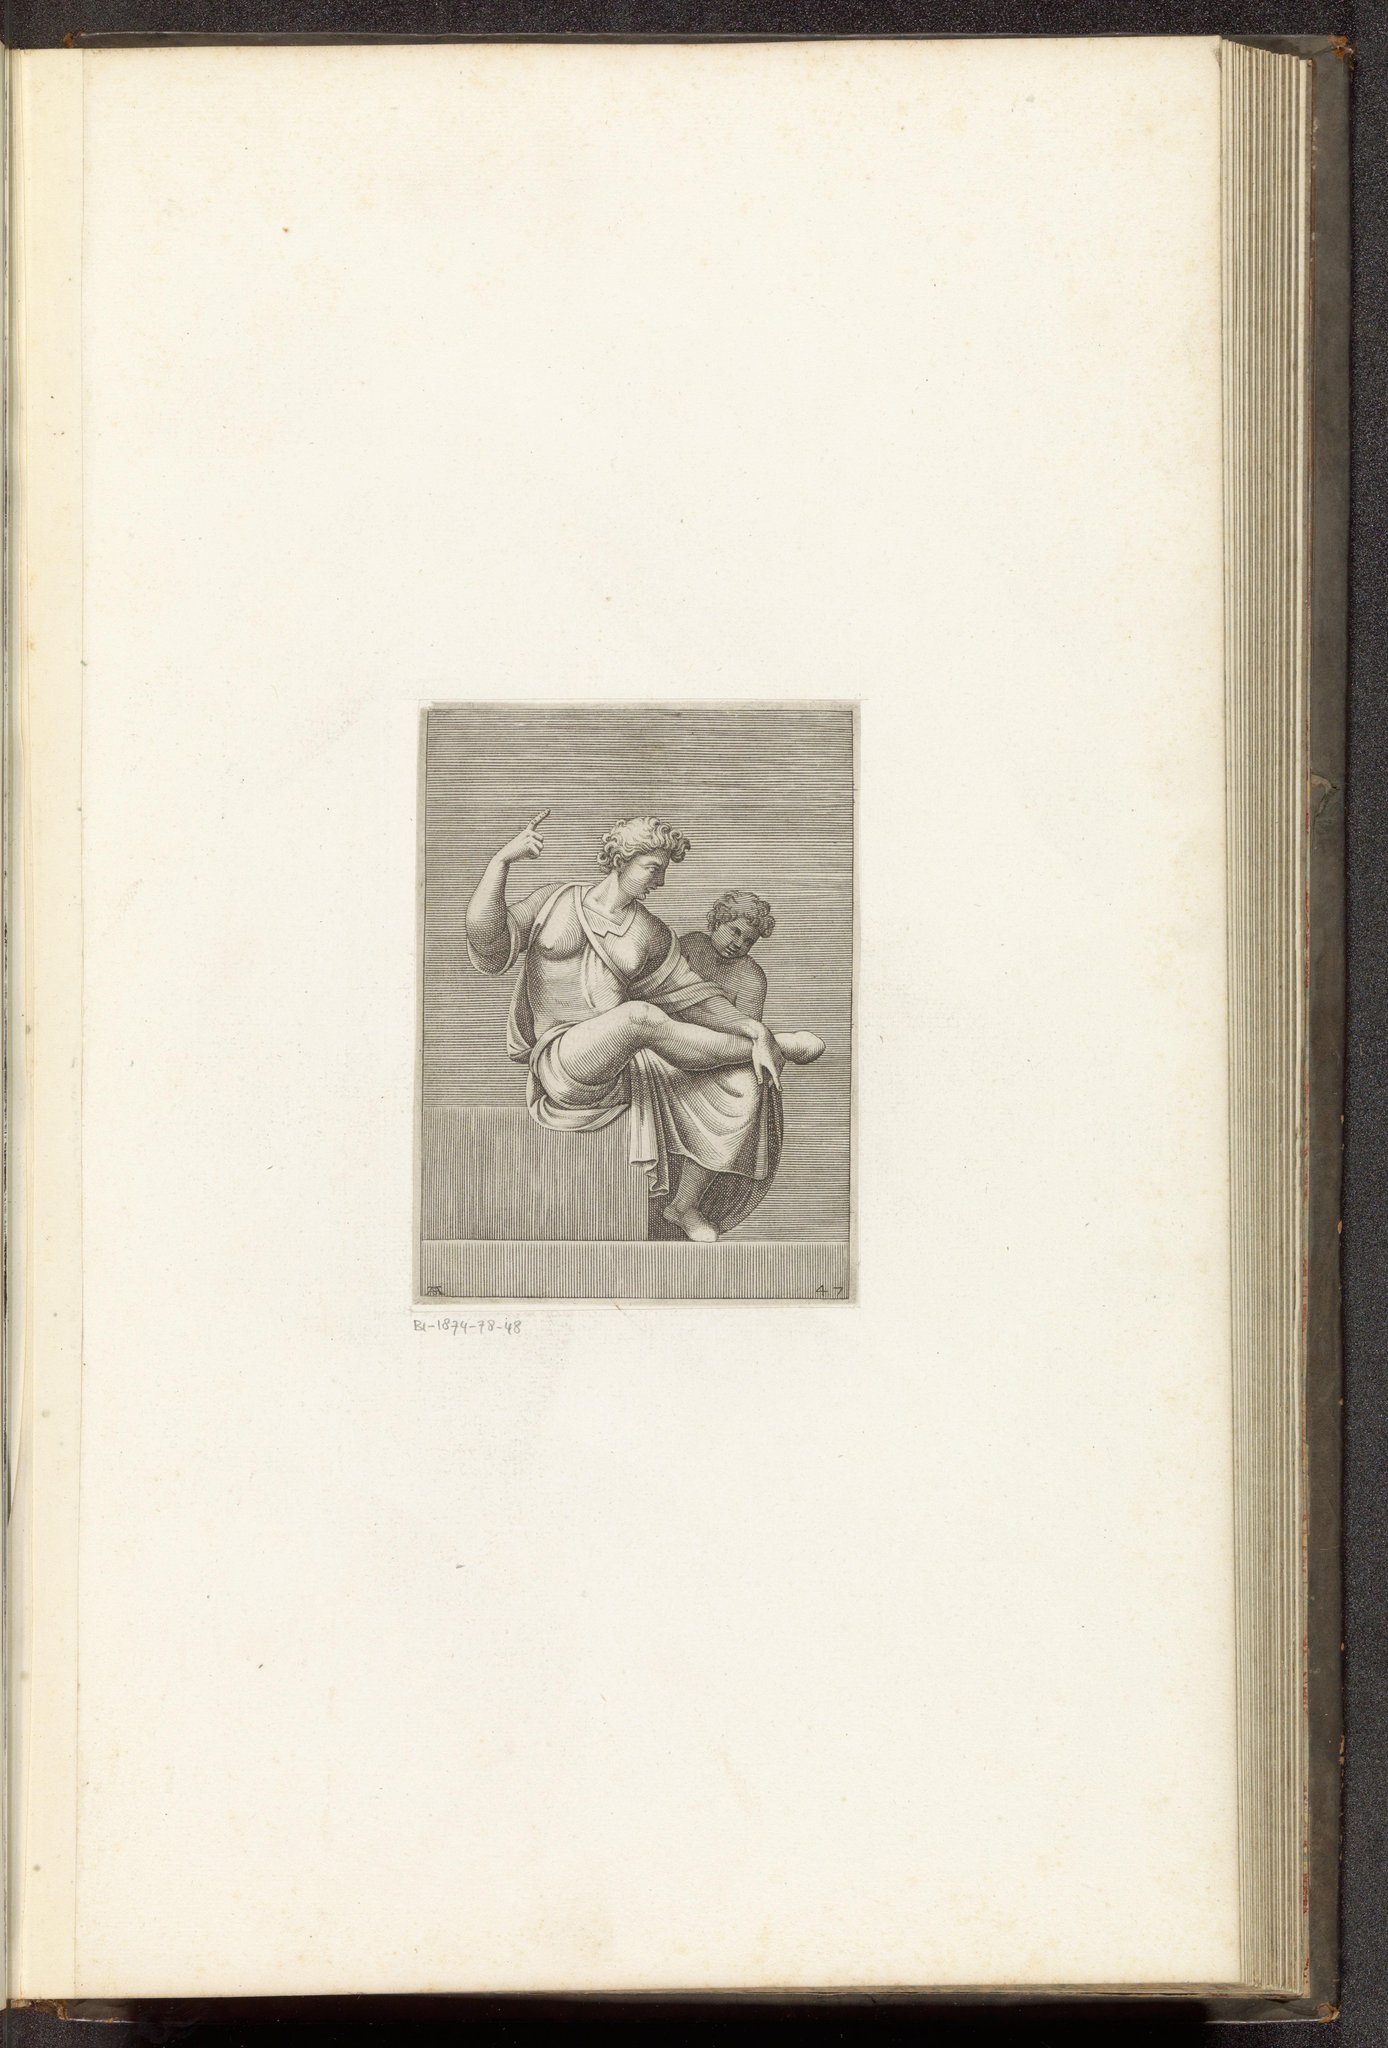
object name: album leaf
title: Zittende jongeman en een kind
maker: adamo scultori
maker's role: painter, print maker, sculptor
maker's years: 1530-1585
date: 1585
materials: paper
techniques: engraving, intaglio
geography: italy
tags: youth, adolescent, index finger forwards, pointing, indicating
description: Deze prent maakt deel uit van een serie bestaande uit een titelprent en 72 prenten naar schilderingen door Michelangelo in de Sixtijnse Kapel in het Vaticaan.